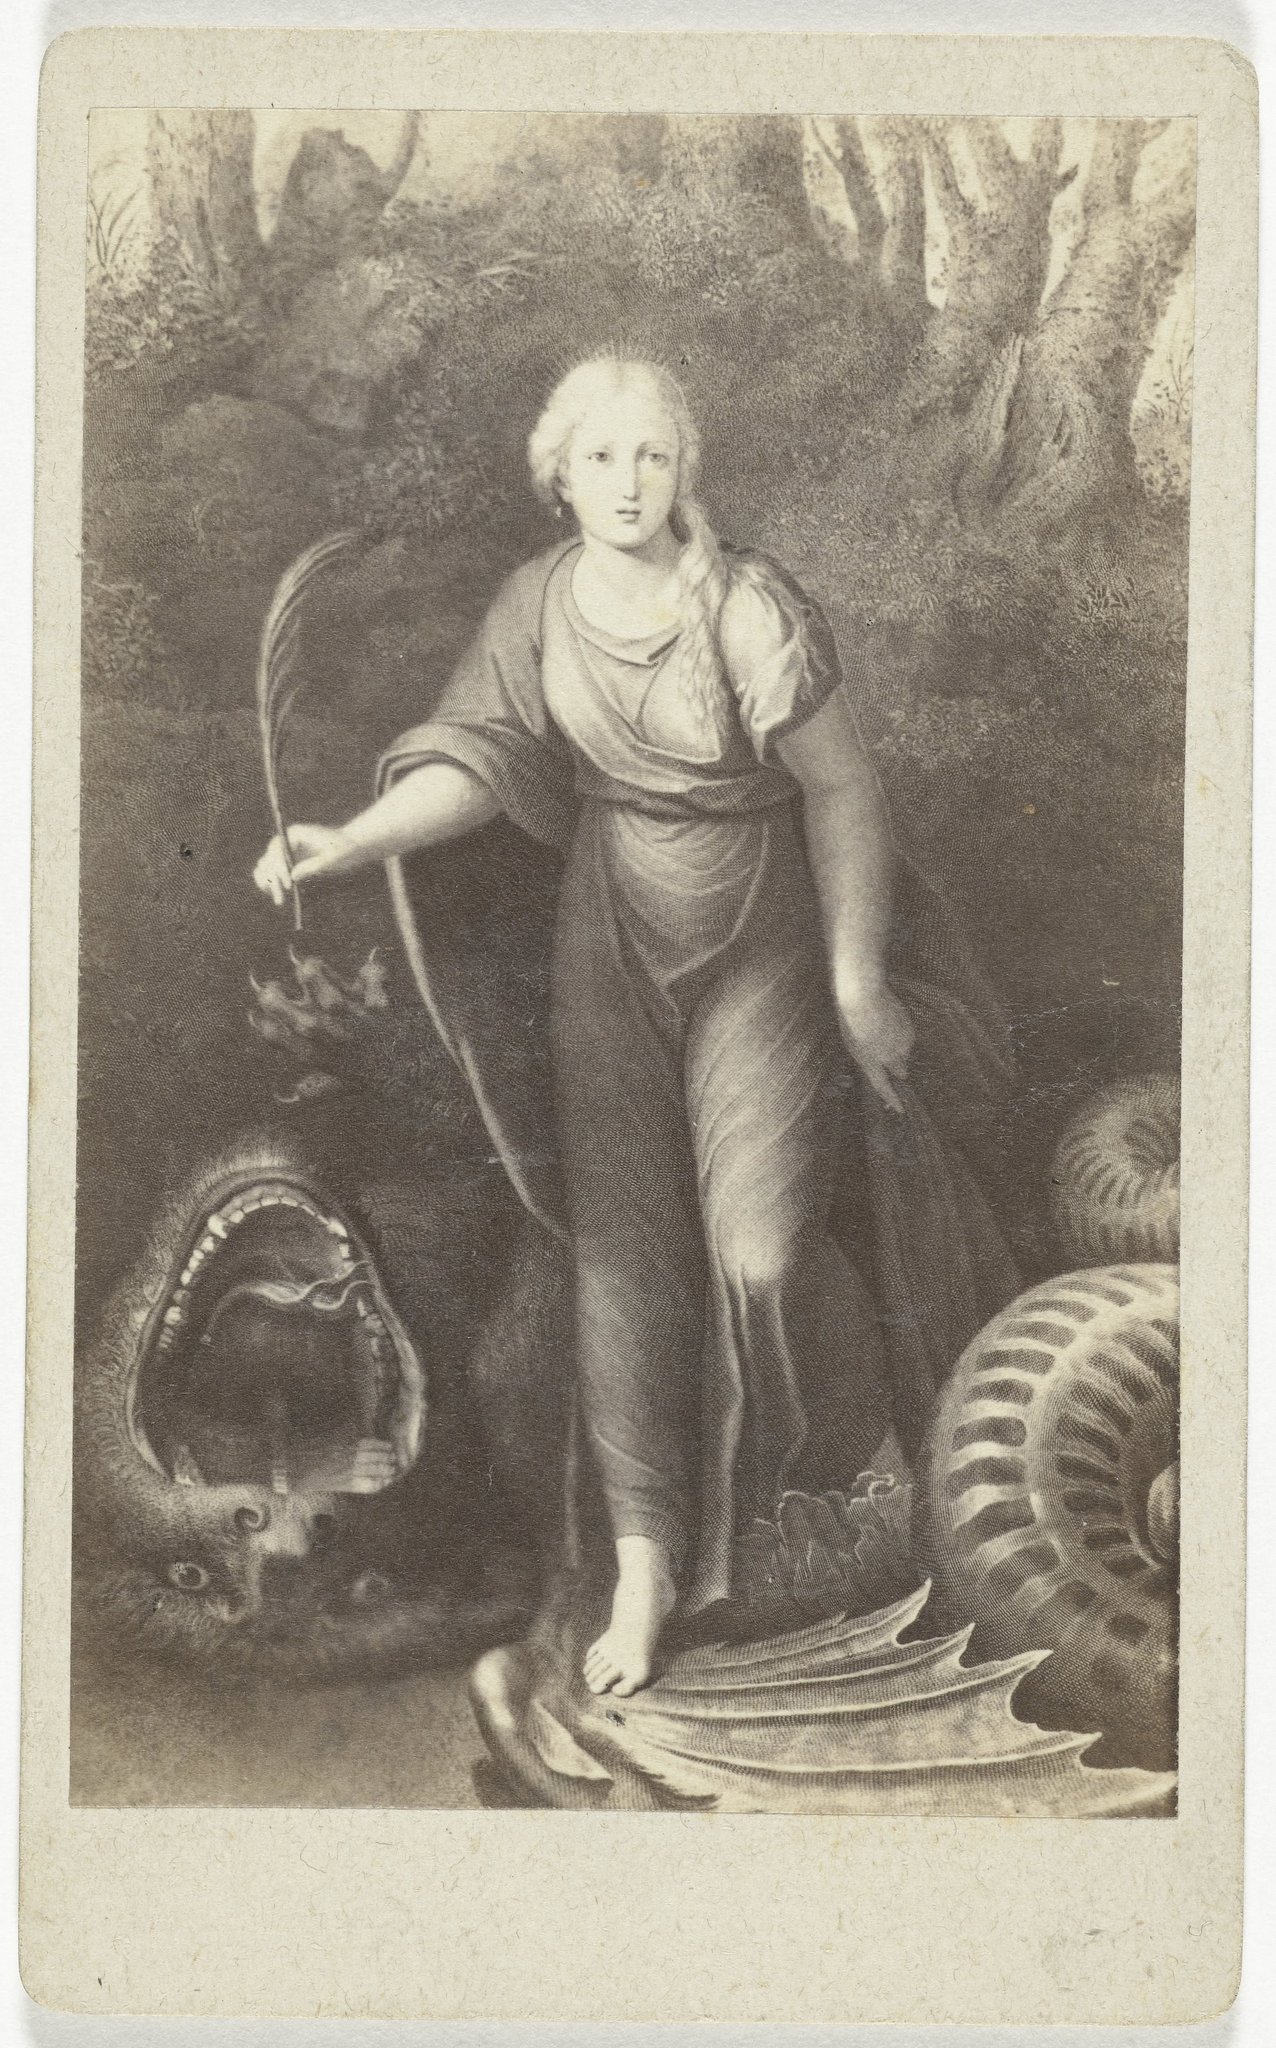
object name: photograph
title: Fotoreproductie van een gravure naar een schilderij van Sainte Marguerite door Rafaël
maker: Anonymous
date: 1850-1900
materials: cardboard, photographic support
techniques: albumen print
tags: the virgin martyr margaret of antioch; possible attributes: cross, crown, dragon (under feet or on chain), (chaplet of) pearls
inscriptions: inscription: ‘Rafaël / 931. / Ste. Marguerite. / Die heilige Margaretha. / St. Margaret.’